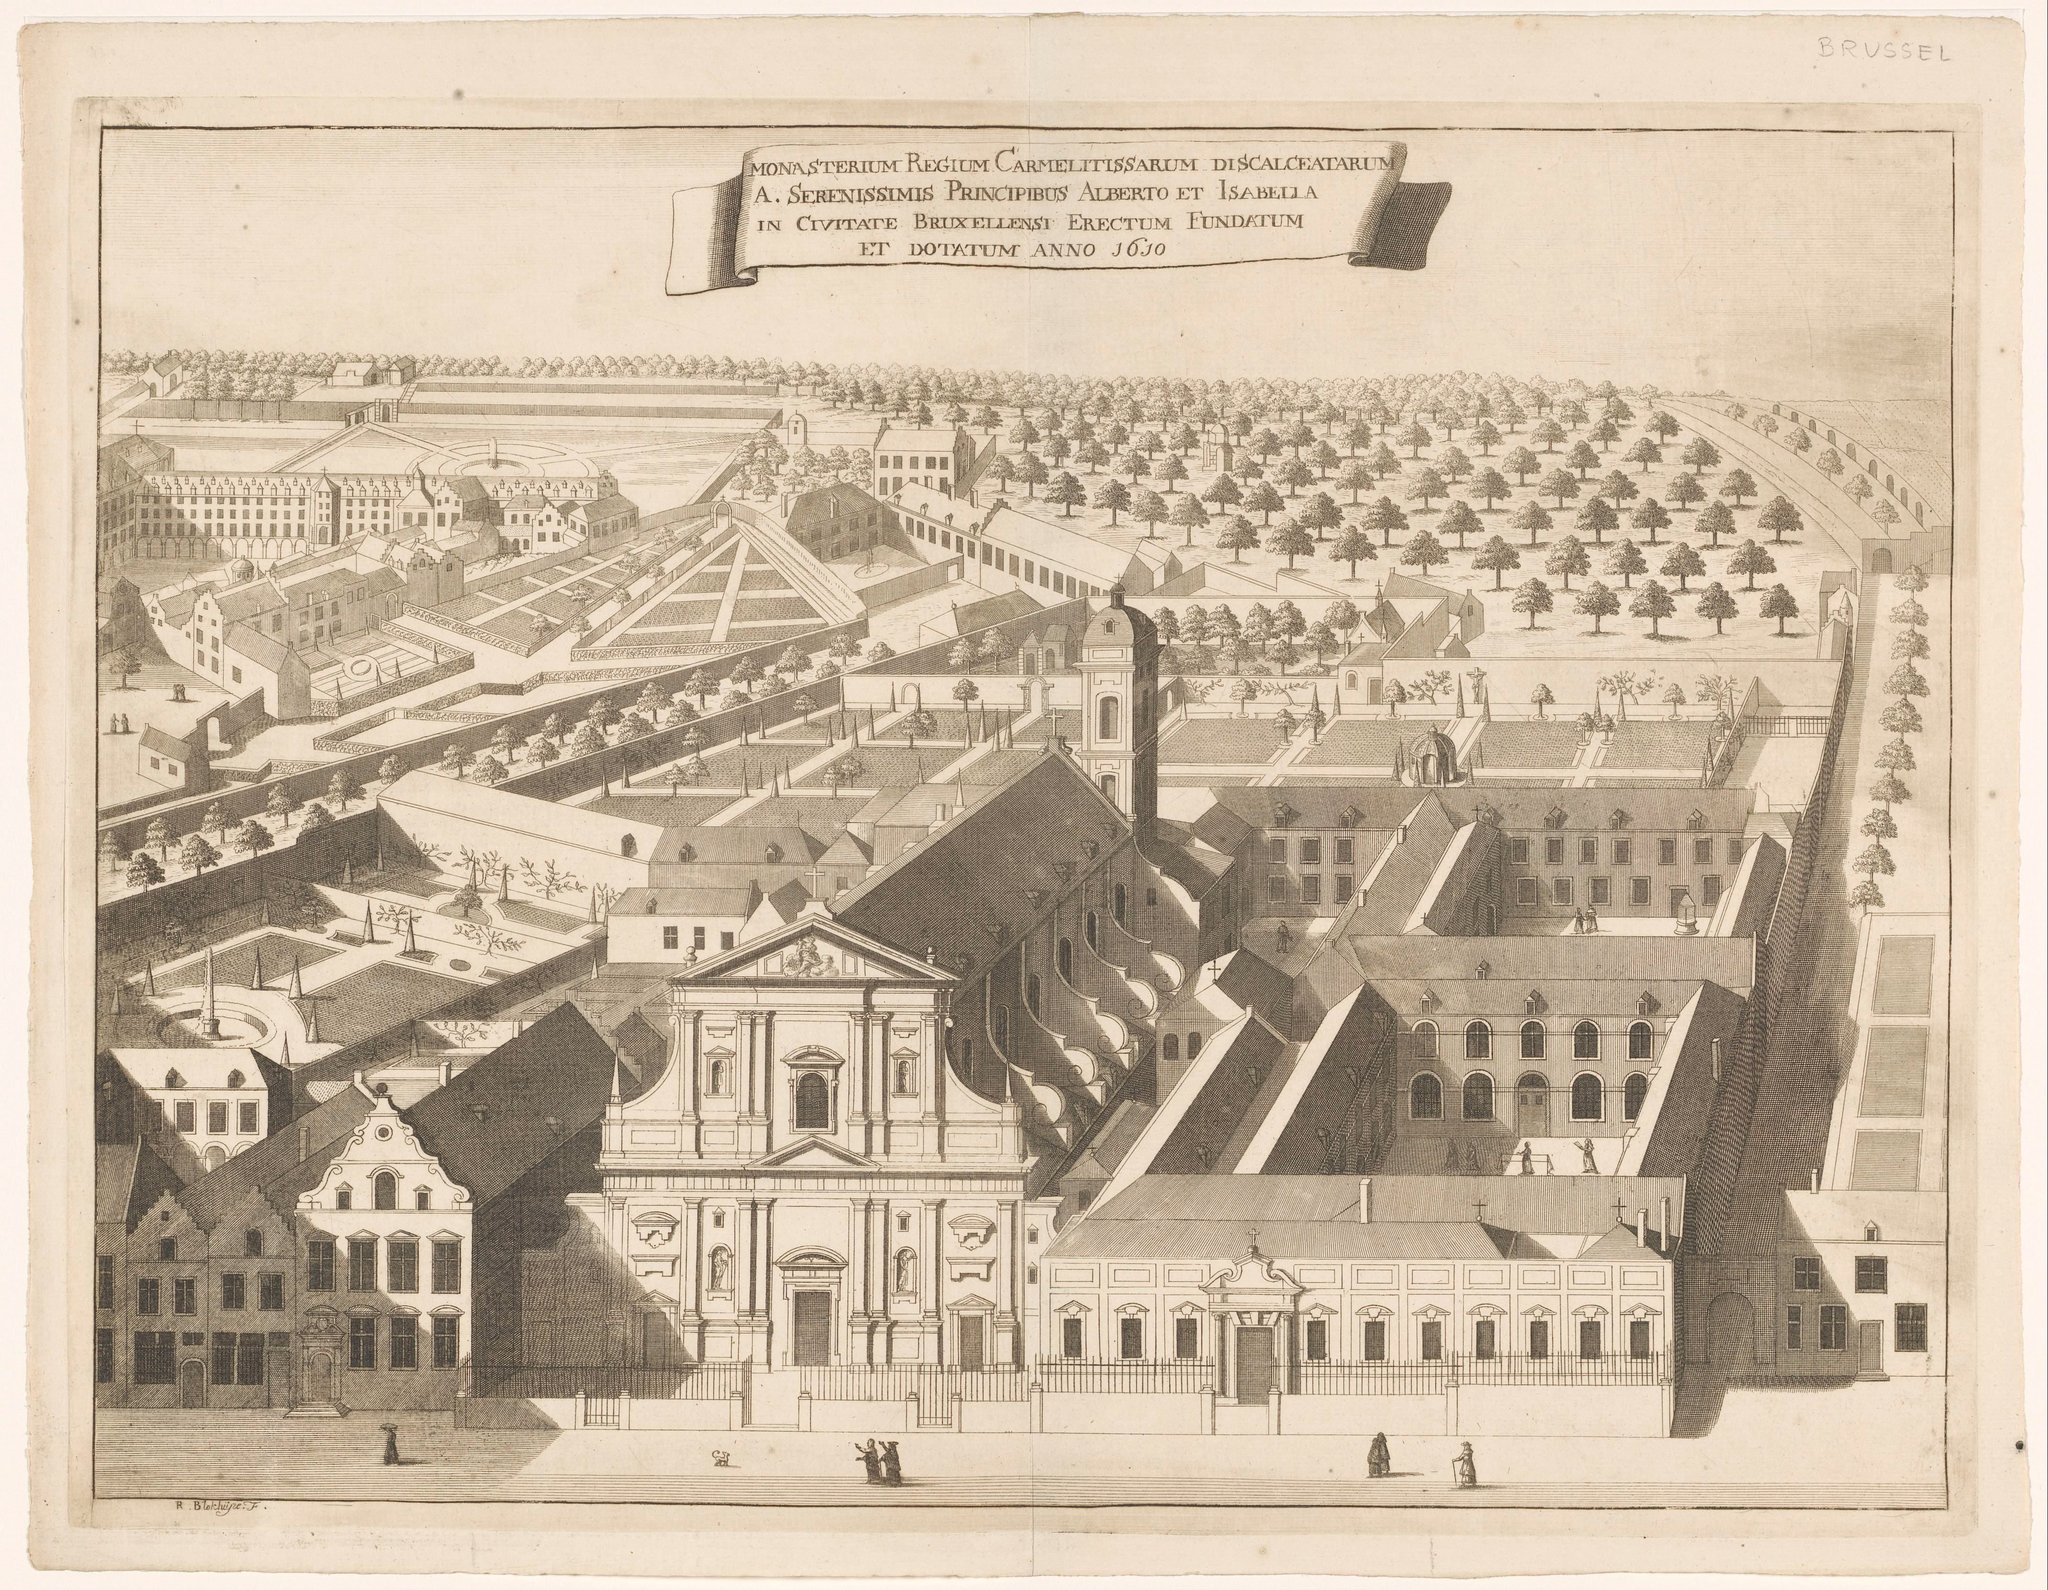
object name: print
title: Gezicht op het Klooster van de ongeschoeide karmelietessen, te Brussel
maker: reynier blokhuysen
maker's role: print maker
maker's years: 1663-1744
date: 1727-1734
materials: paper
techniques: etching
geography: leiden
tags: cloisters ~ monastery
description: Prent ook gebruikt in: Sanderus, Antonius. Groot kerkelyk toneel des Hertogdoms van Brabant (...). Den Haag: Christiaan van Lom, 1727. En in: Sanderus, Antonius. Antonii Sanderi presbyteri Chorographia sacra Brabantiæ. 3 delen. Den Haag: Christiaan van Lom, 1726-1727, dl. 2 (1727). En in: Sanderus, Antonius. Le grand theatre sacré du duché de Brabant (...). 4 delen. Den Haag: Gerard Block, 1729-1734.